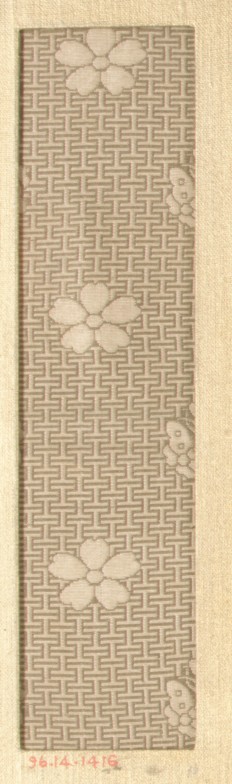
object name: piece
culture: japanese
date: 1701-1900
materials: silk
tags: flowers